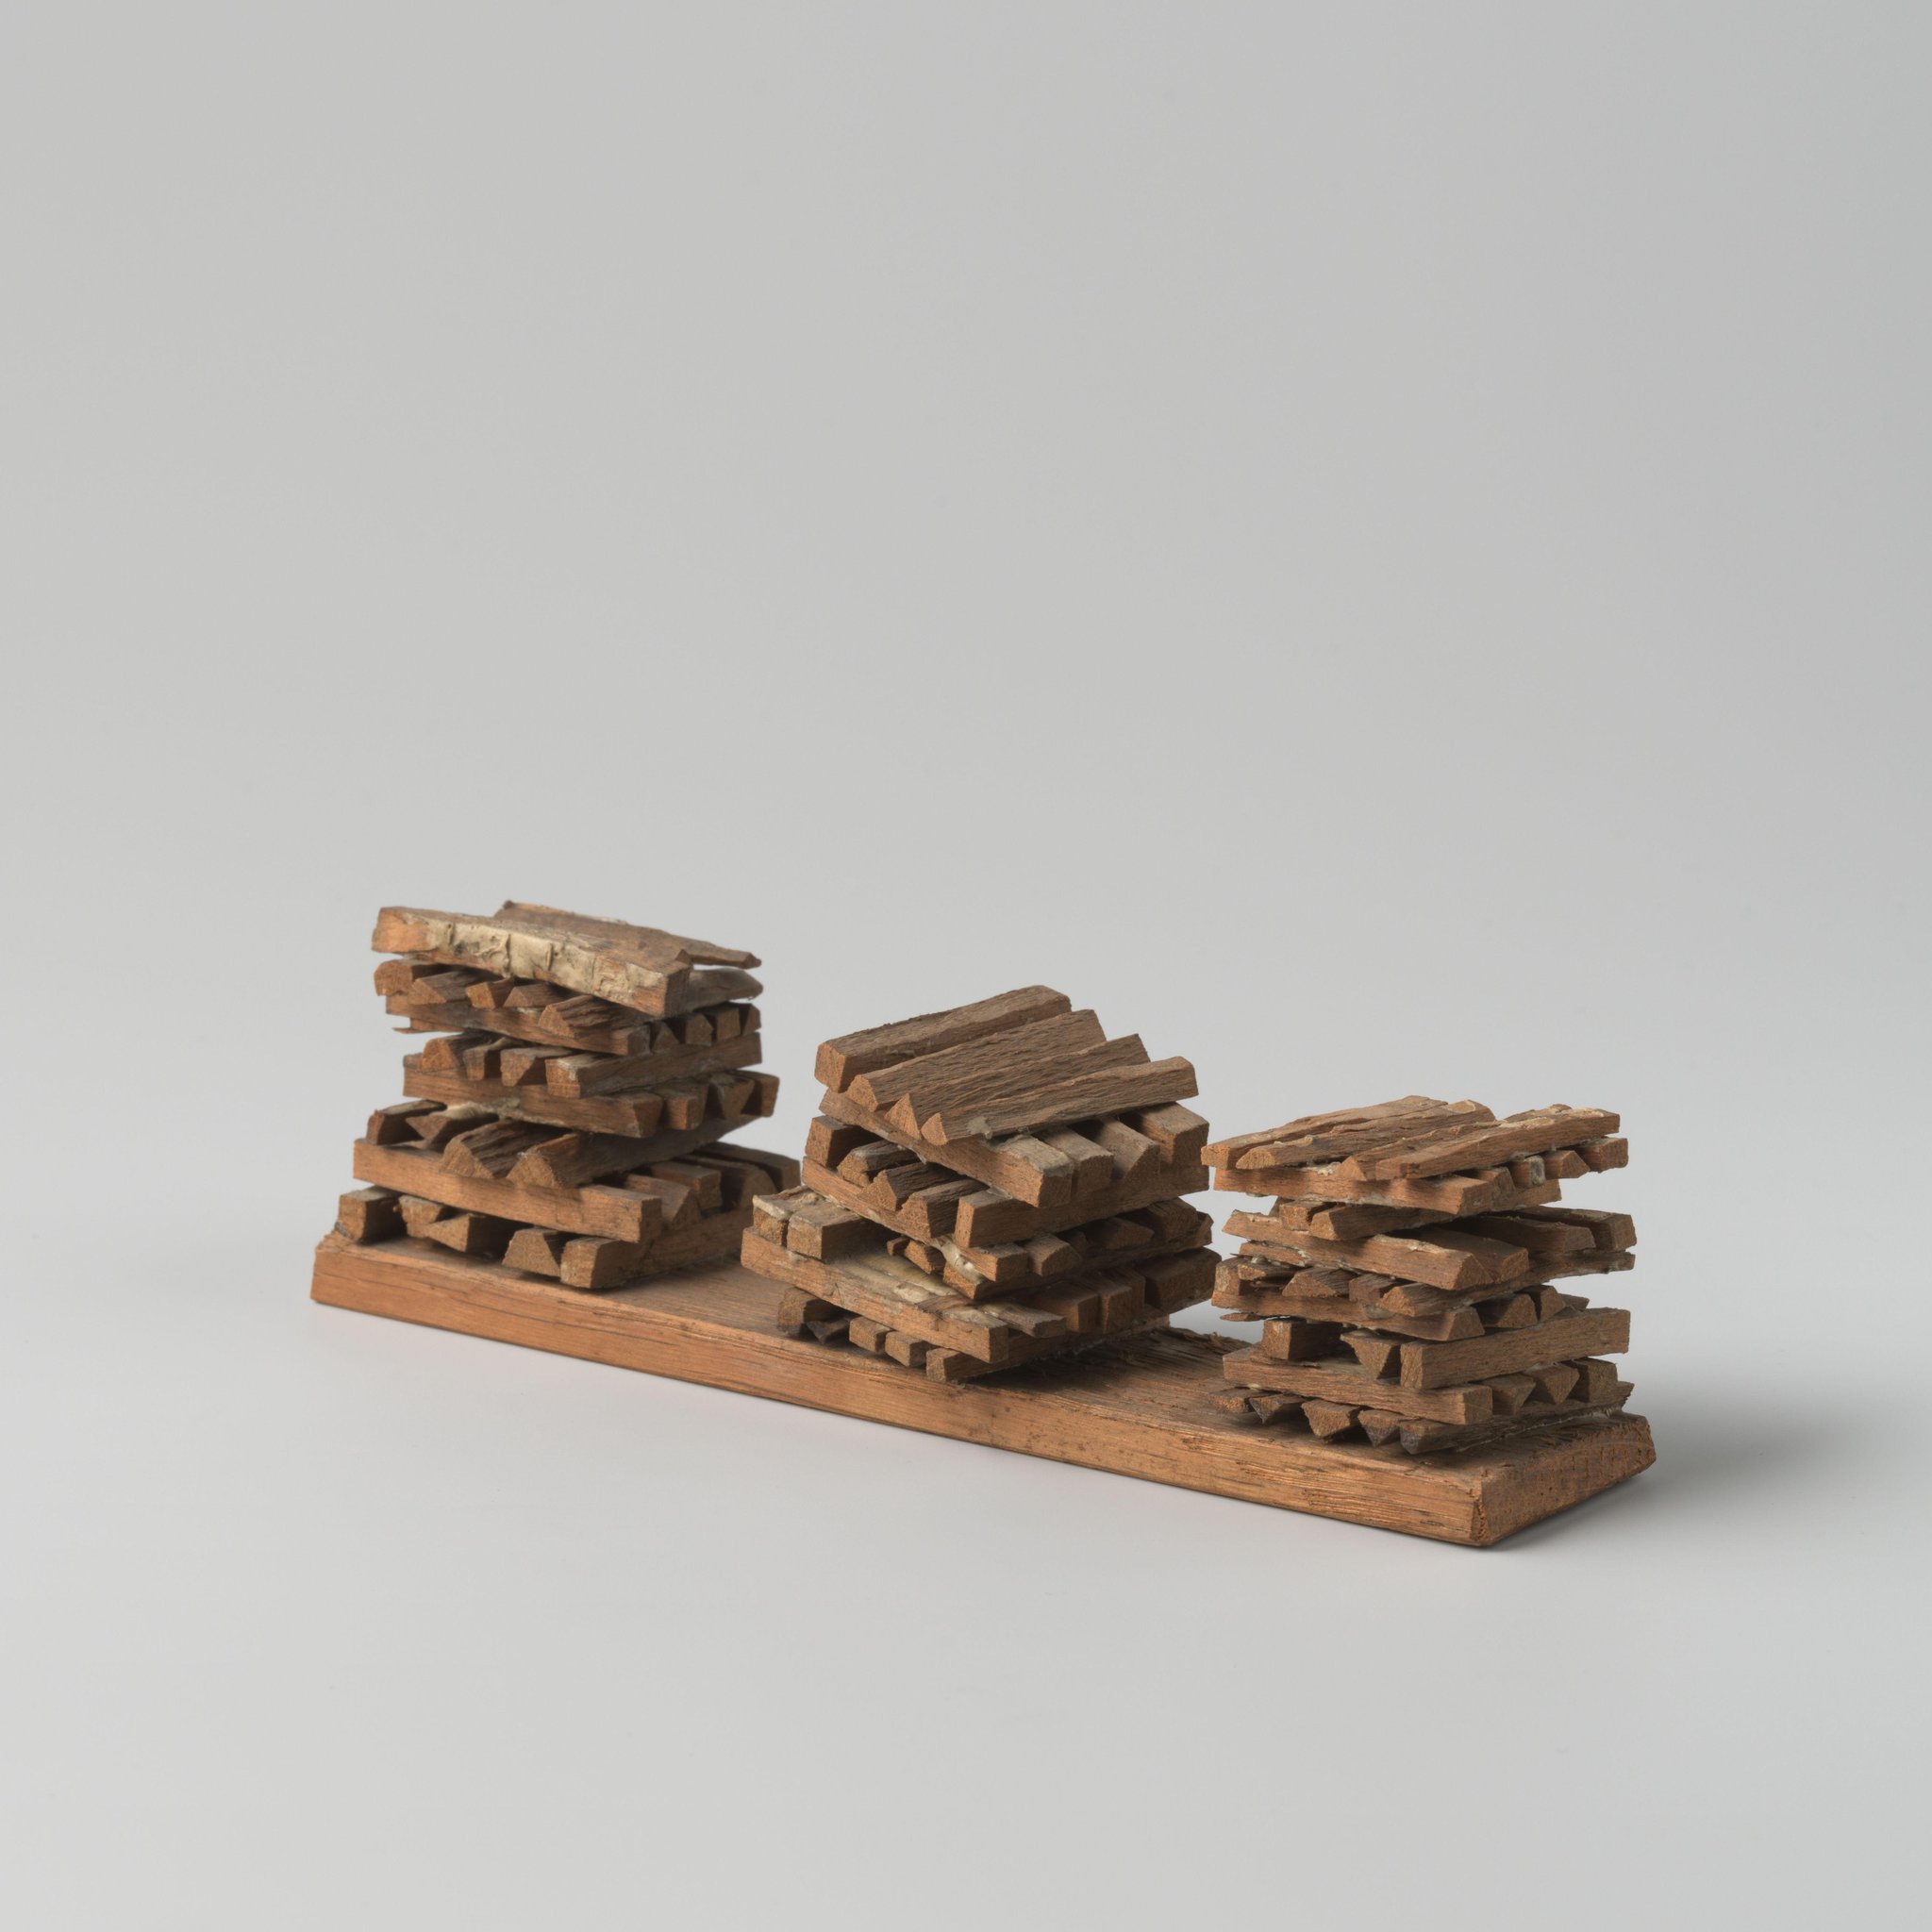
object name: miniature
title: Plank waarop drie stapels gekloofd beukenhout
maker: Anonymous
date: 1690-1710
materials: wood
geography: amsterdam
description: Houtvoorraad, bestaande uit een withouten plank, waarop drie stapels gekloofd beukenhout zijn vastgeplakt.